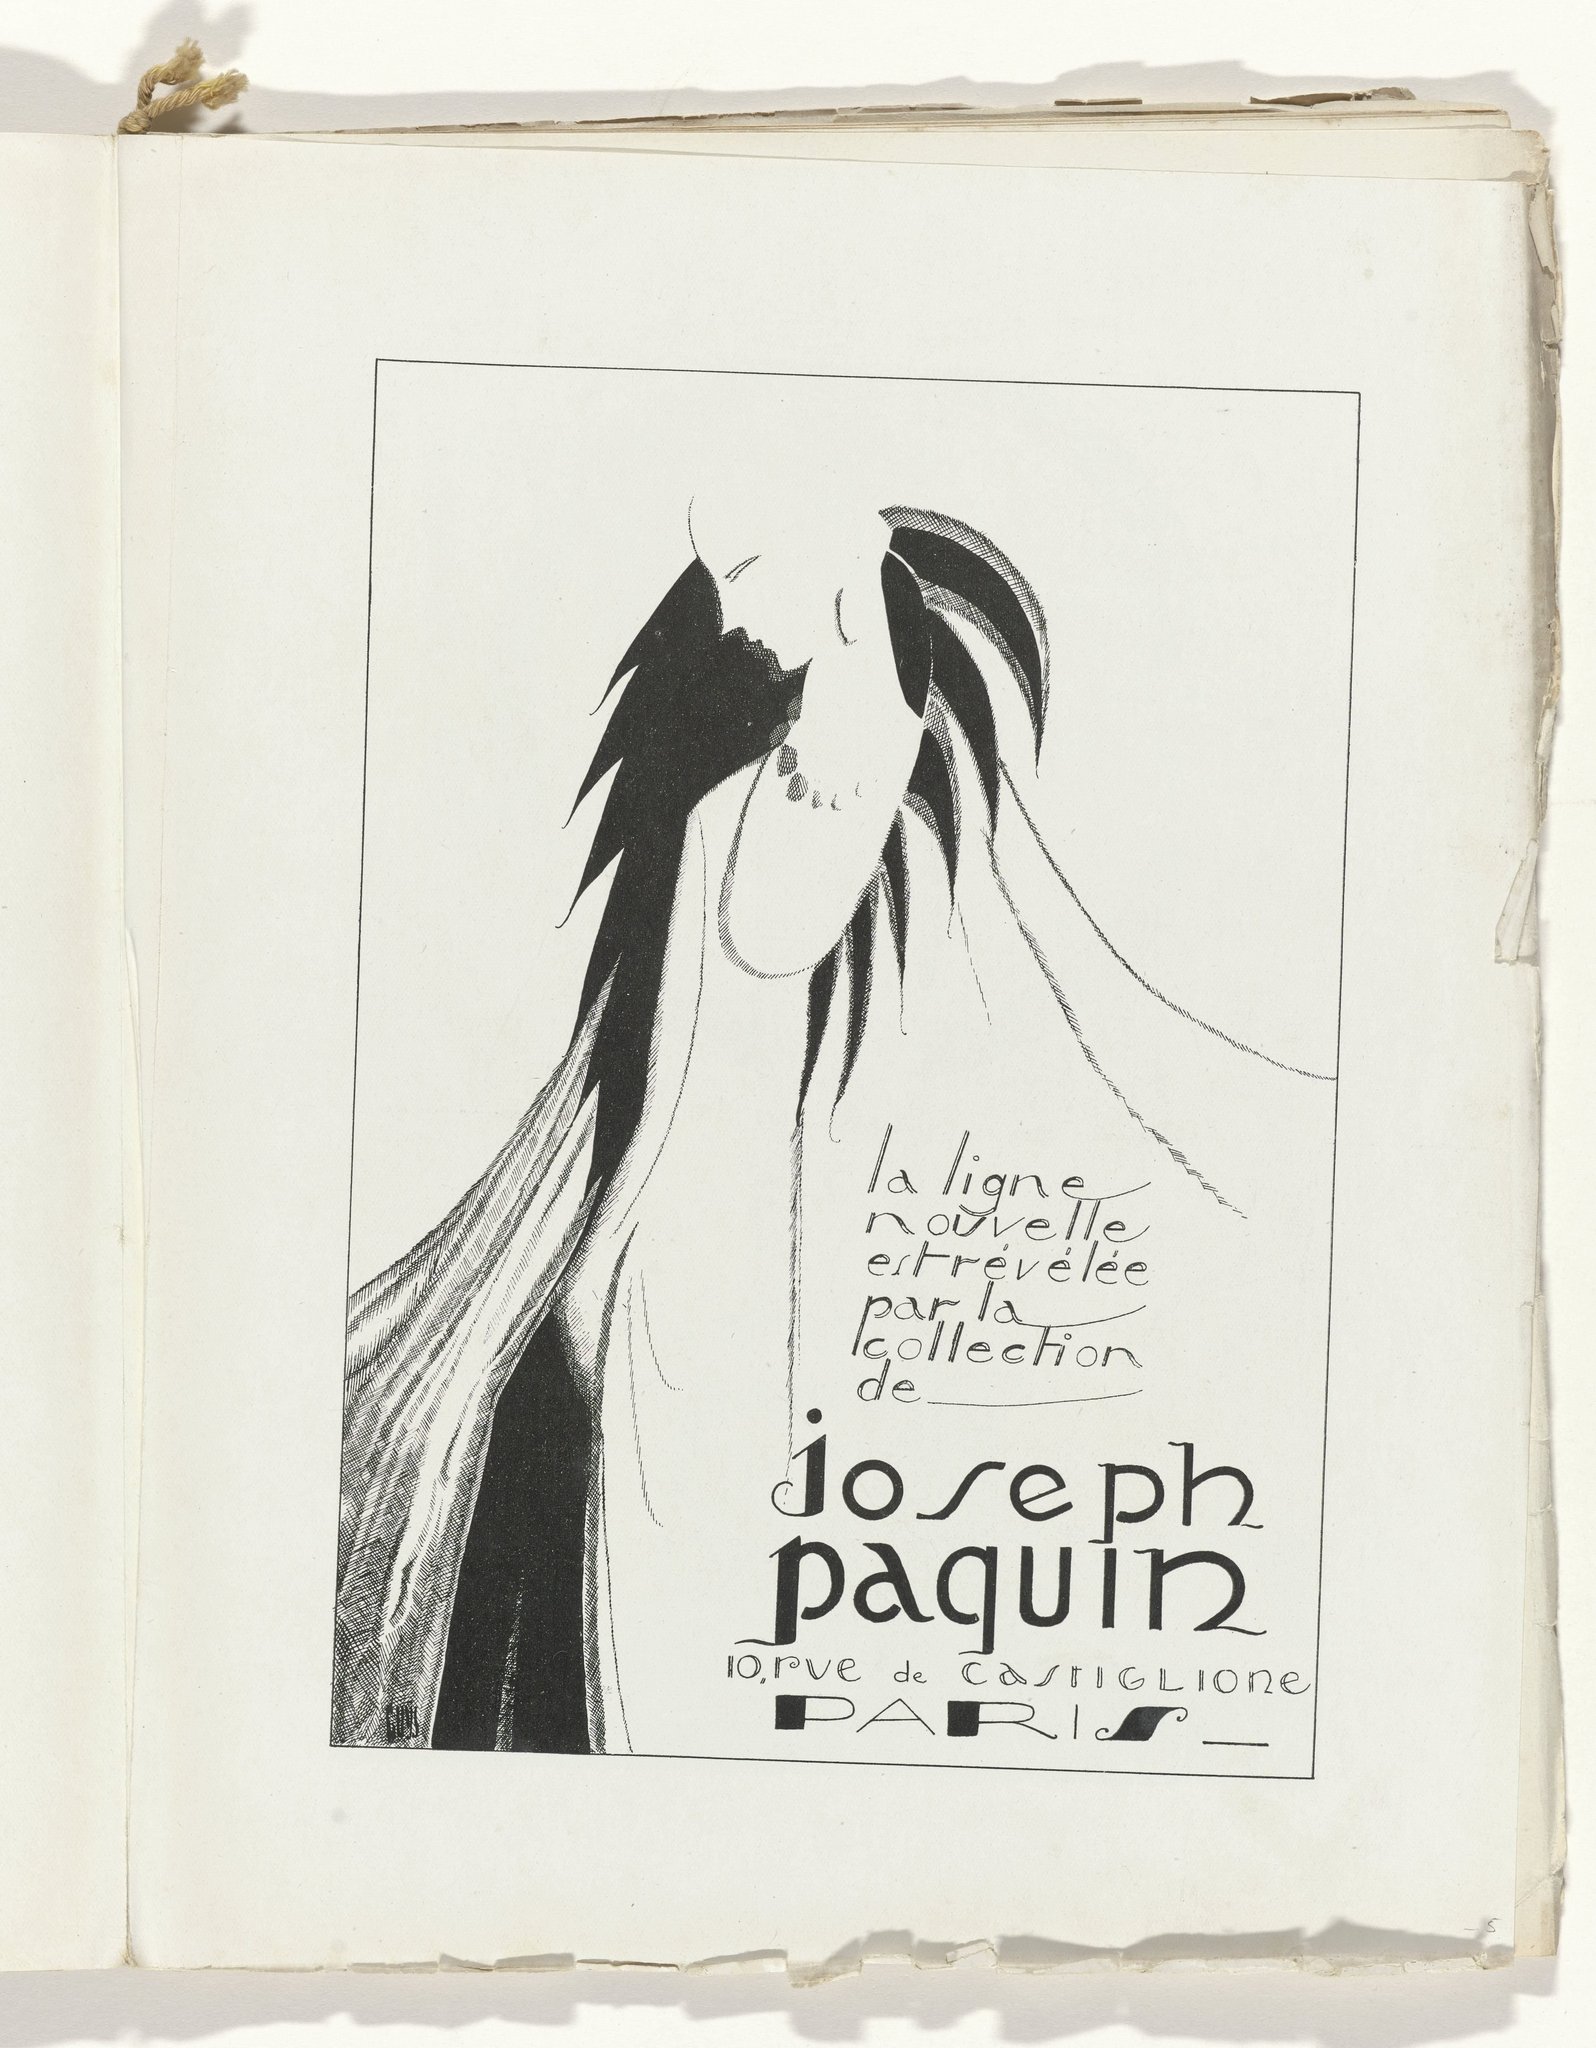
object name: magazine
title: Art - Goût - Beauté, Feuillets de l' élégance féminine, Mars 1929, No. 103, 9e Année, p. 5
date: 1929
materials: paper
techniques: photography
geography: paris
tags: coat (+ women's clothes), fashion plates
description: Advertentie voor de collectie van Joseph Paquin. Pagina uit het modetijdschrift Art-Goût-Beauté (1920-1933).